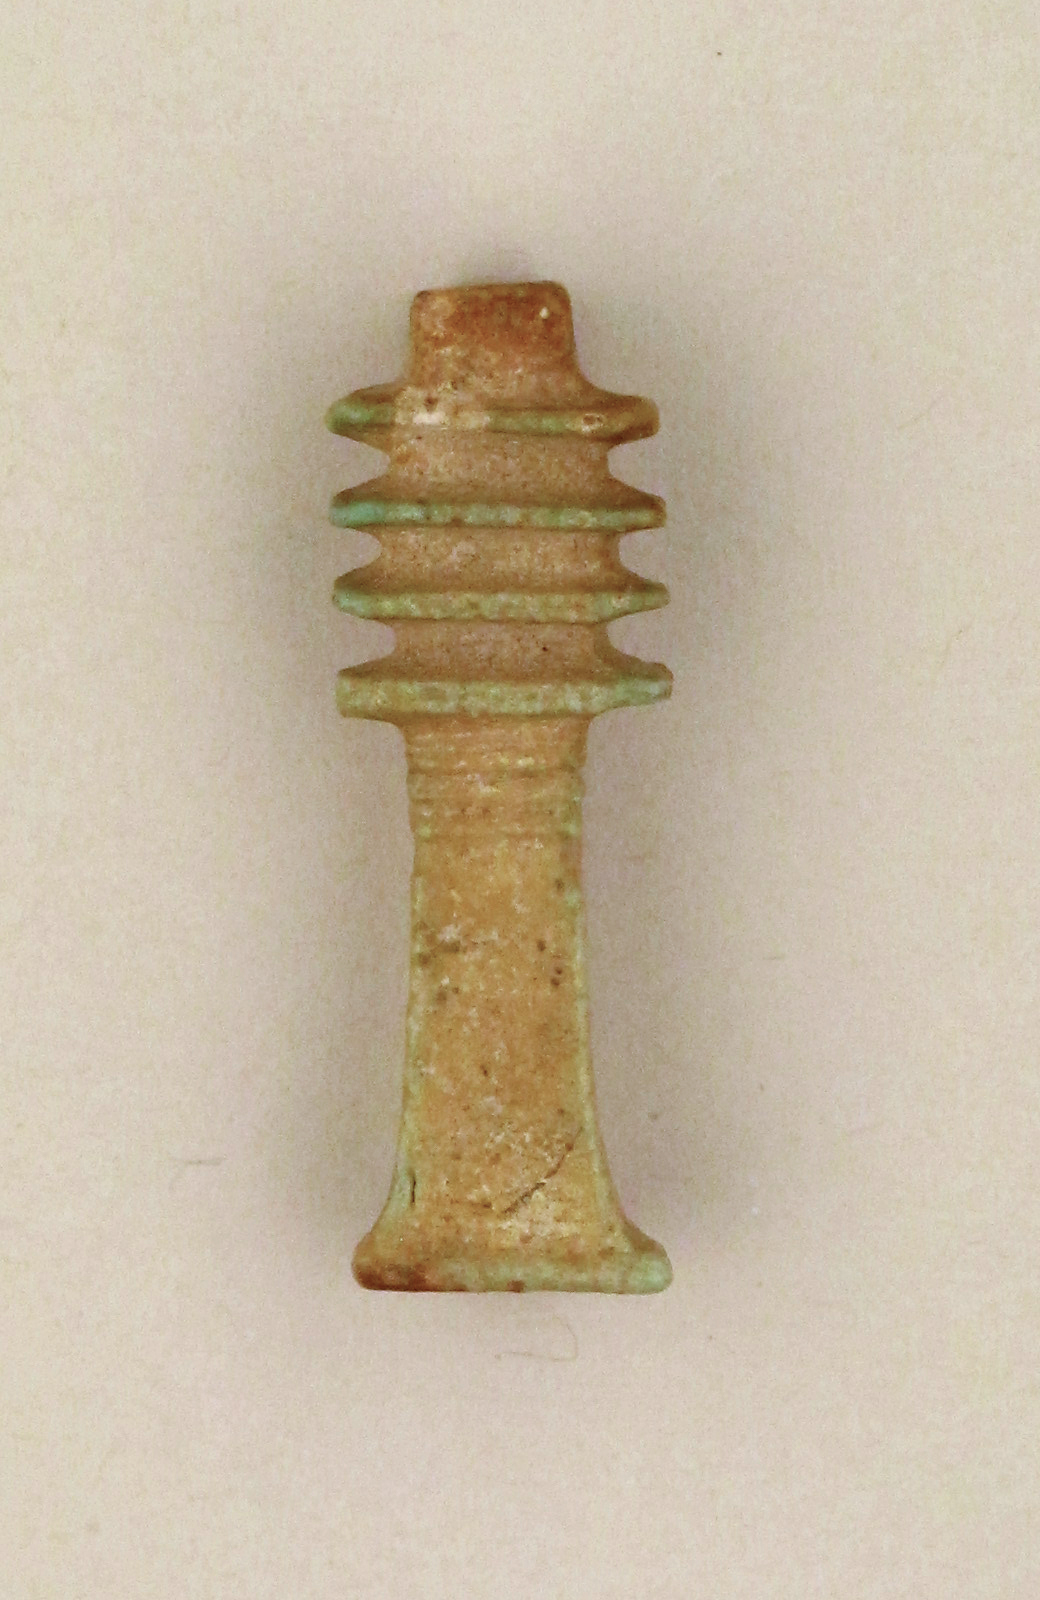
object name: amulet, djed pillar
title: Faience djed-pillar amulet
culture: egyptian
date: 664-630 BCE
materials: faience